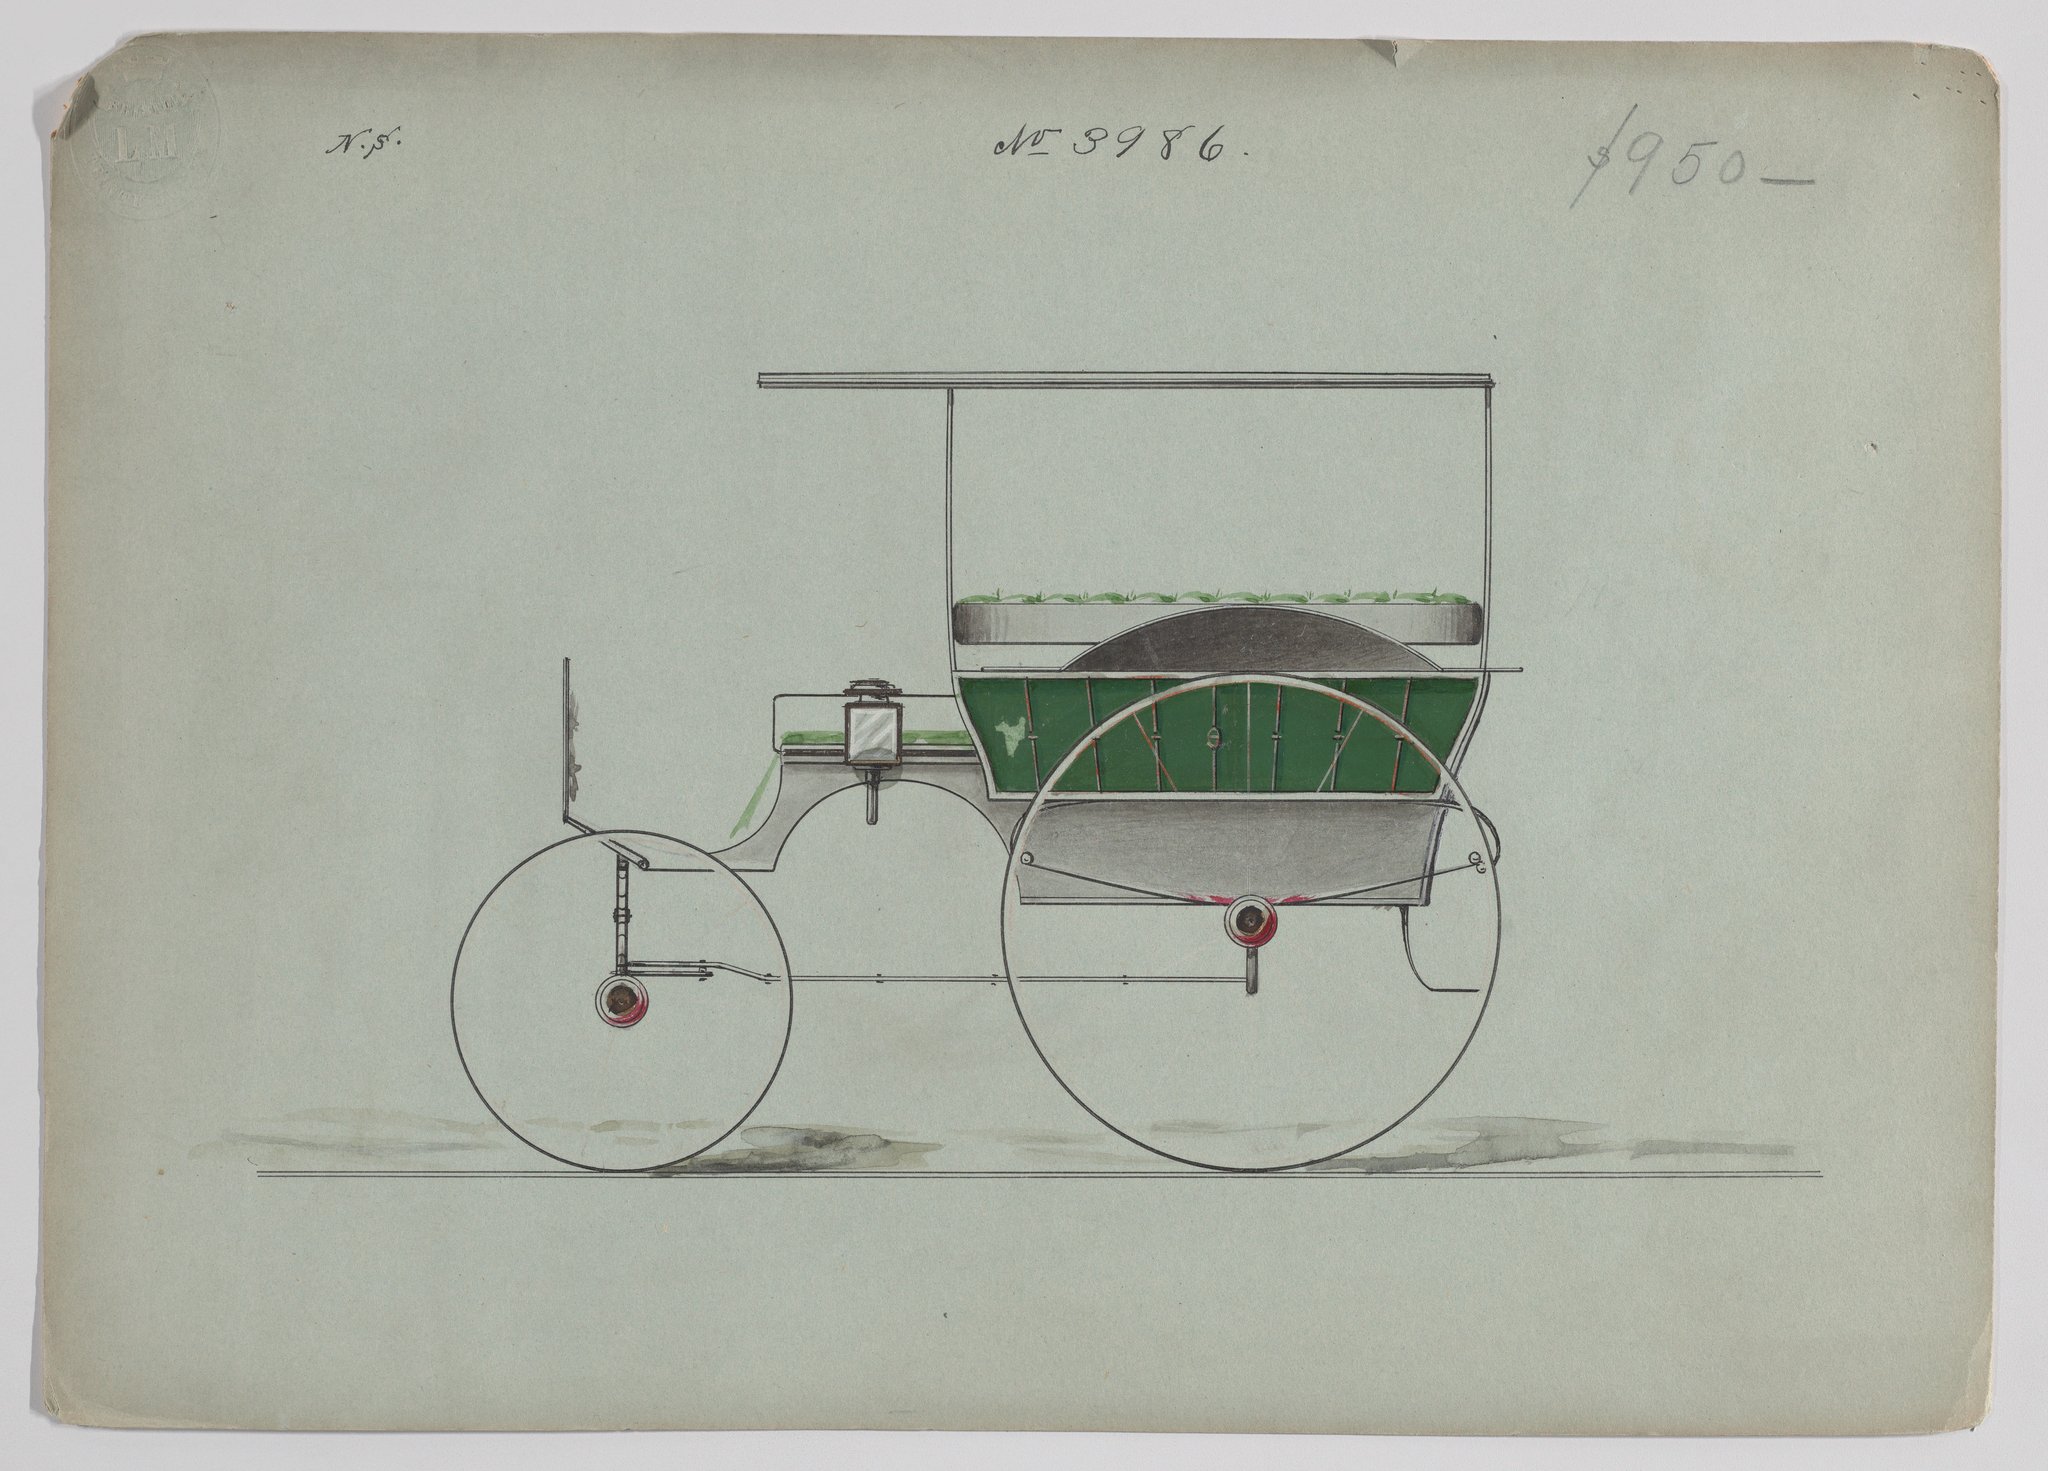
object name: drawing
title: Design for Omnibus or Wagonette, no. 3986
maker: brewster & co.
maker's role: manufacturer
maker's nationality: american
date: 1887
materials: gouache, ink, watercolor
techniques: pen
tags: carriages